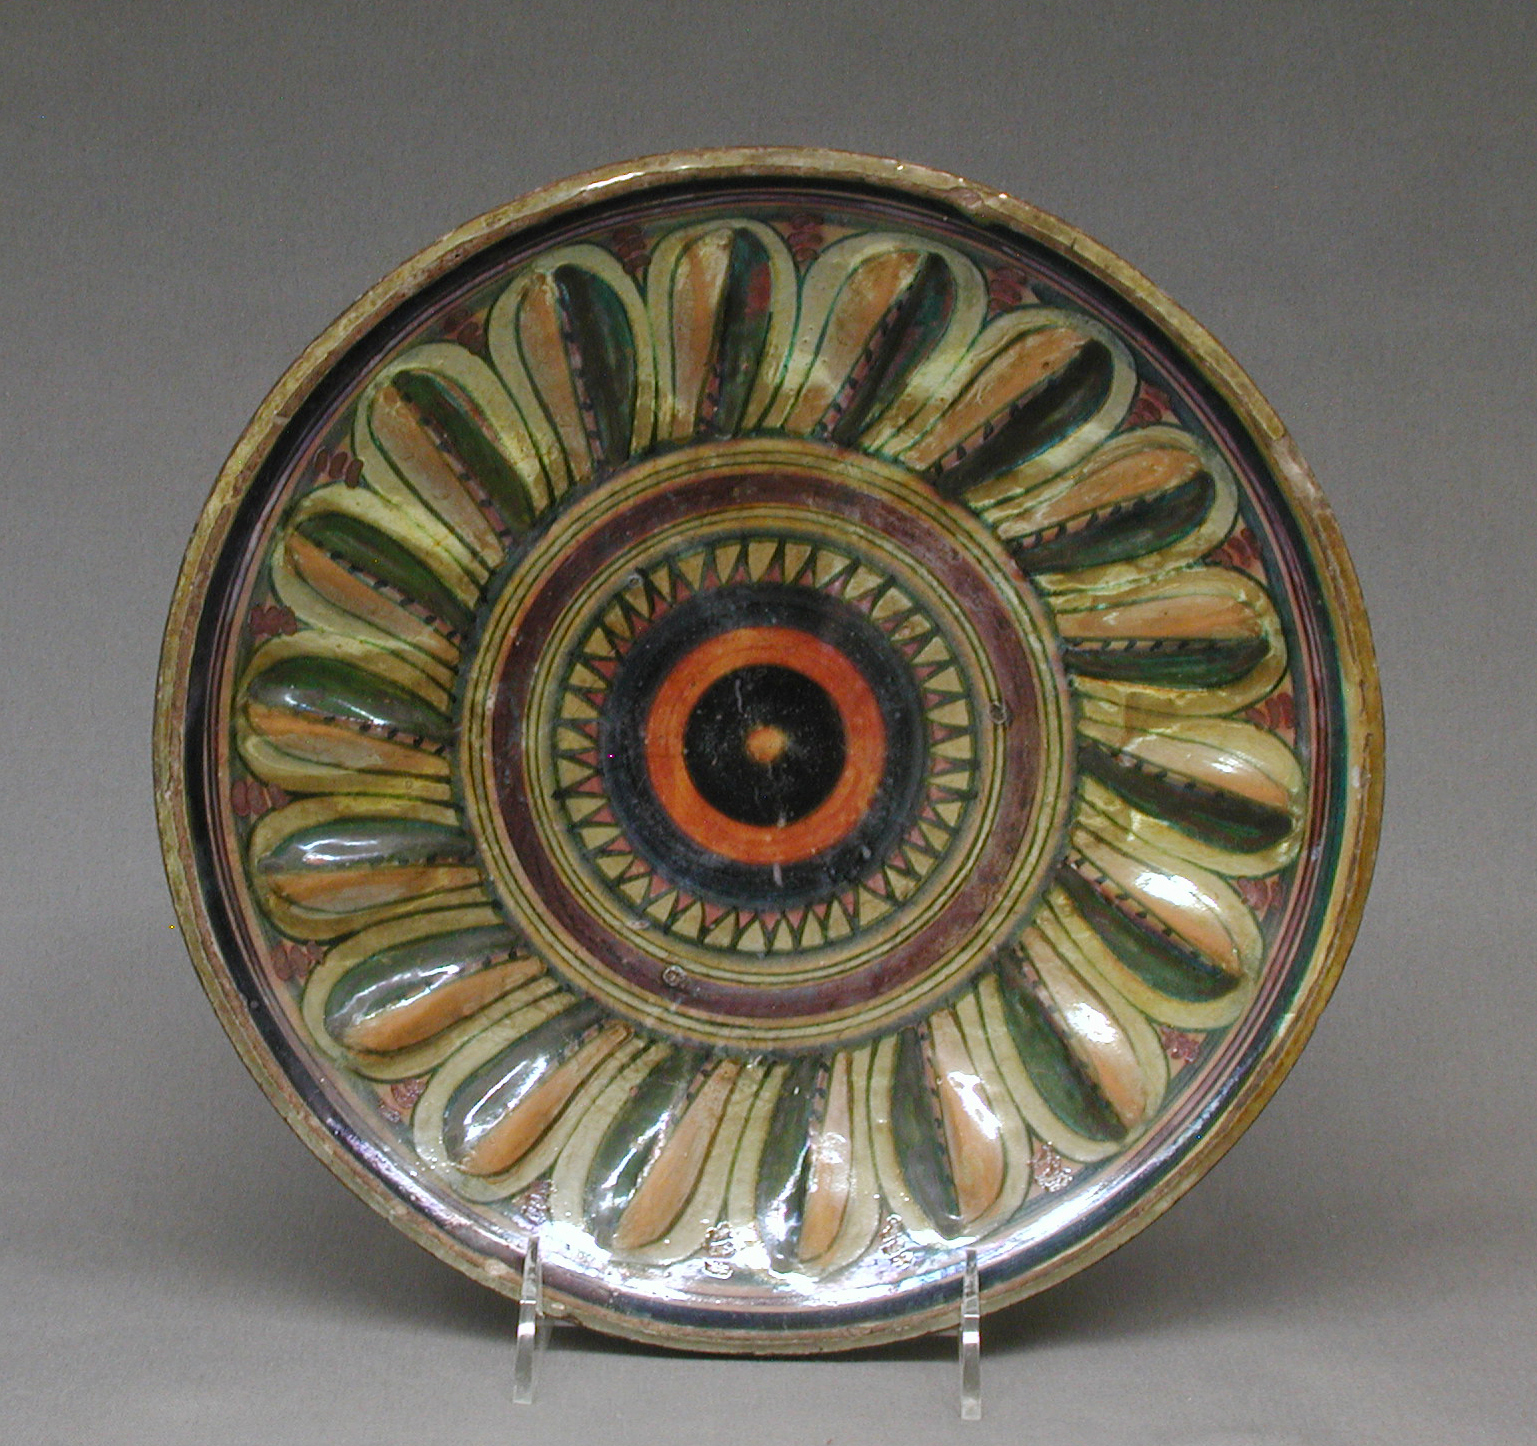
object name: plate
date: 1501-1600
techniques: maiolica, glazing